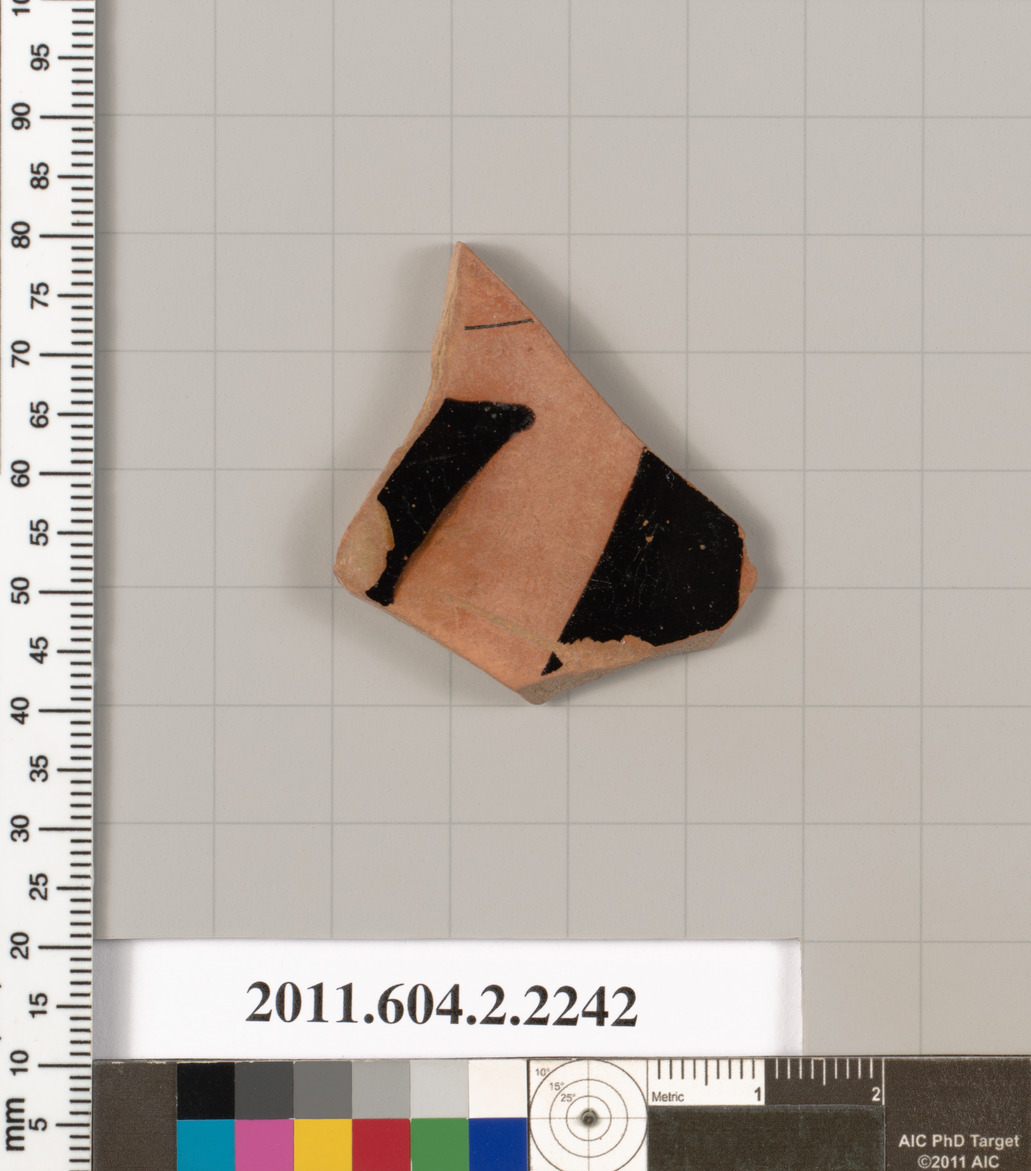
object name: pot fragment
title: Terracotta fragment of a pot; unglazed on the inside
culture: greek, attic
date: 450-426 BCE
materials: terracotta